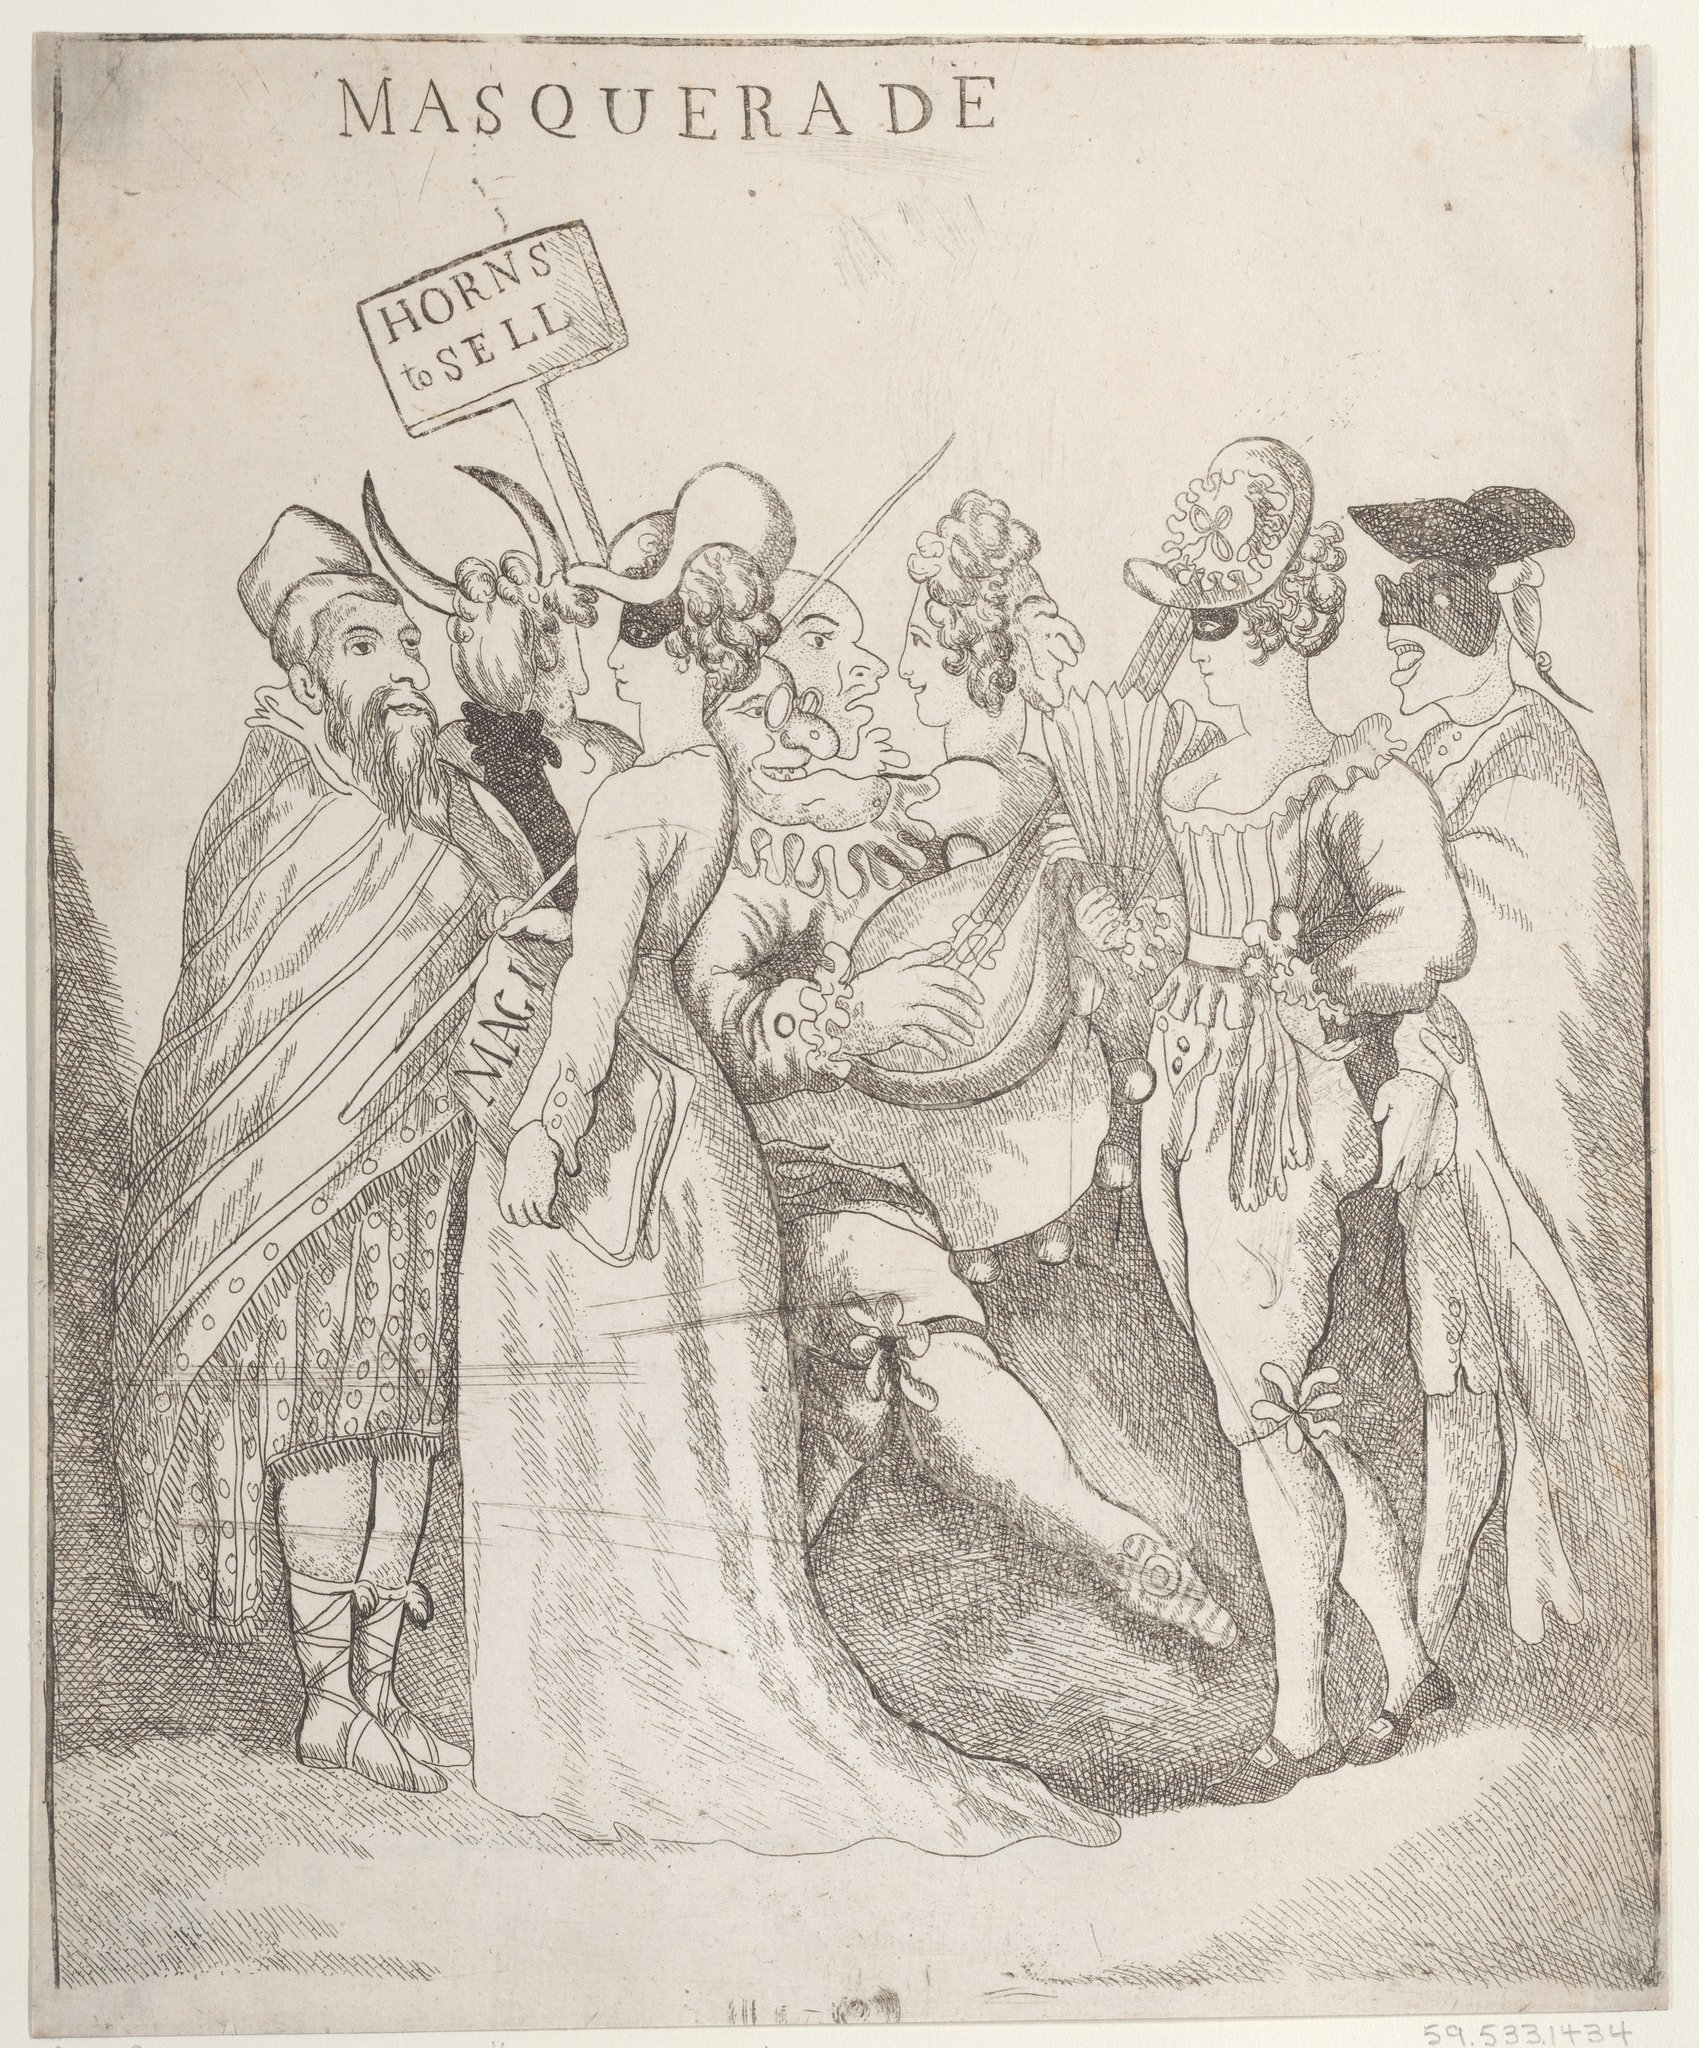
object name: print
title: Masquerade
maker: thomas rowlandson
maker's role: artist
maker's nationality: british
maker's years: 1757-1827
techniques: etching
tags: masks,men,women,musicians